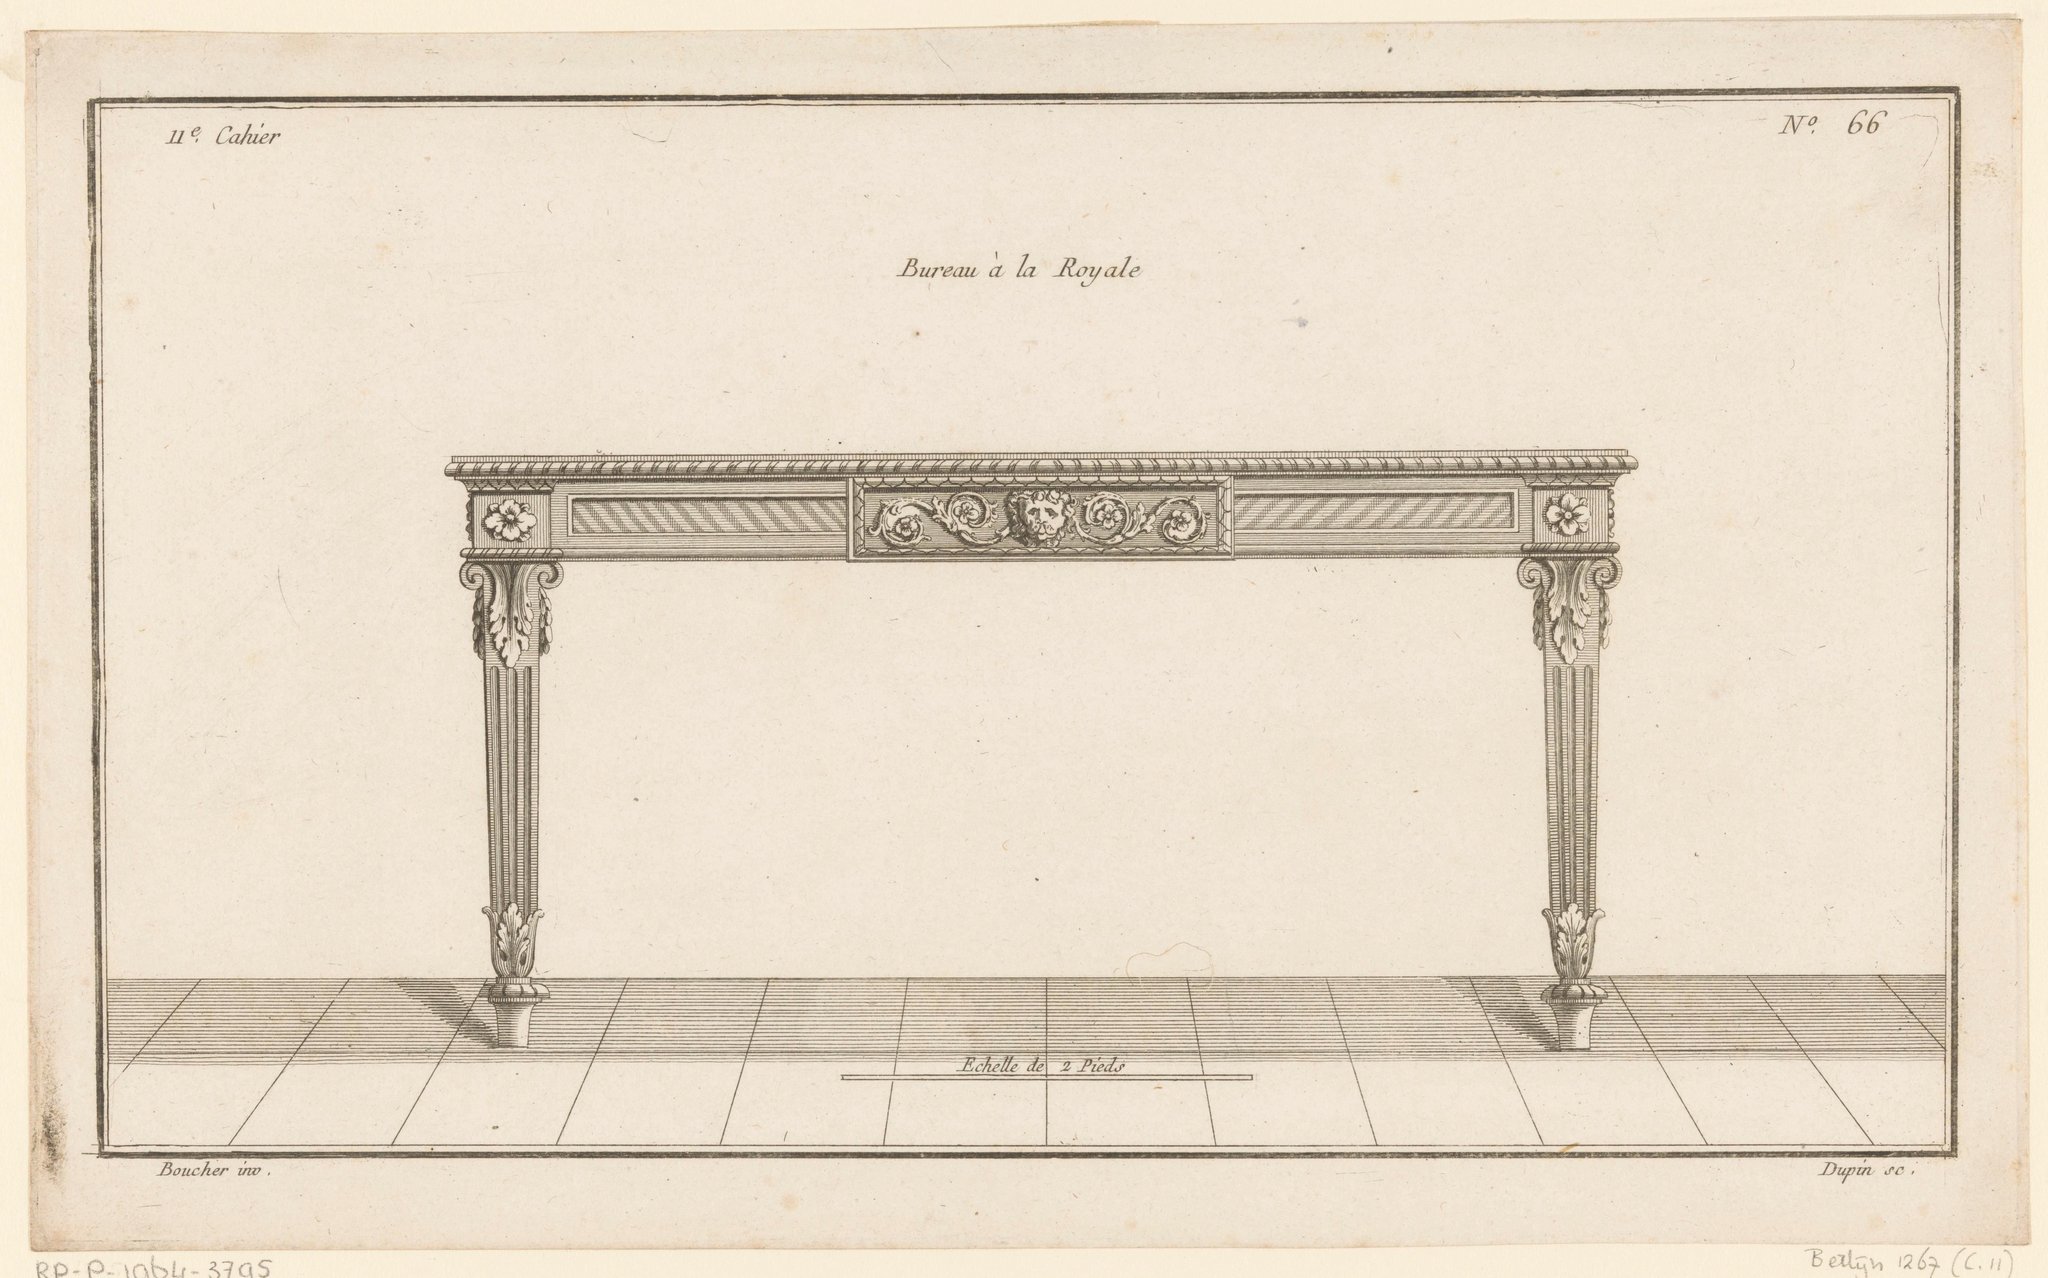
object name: ornament print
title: 11e Cahier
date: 1772-1779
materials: paper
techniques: engraving, etching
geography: paris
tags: writing-table, writing-desk, lion's head ~ ornament, ornament derived from plant forms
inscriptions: collector's mark: Lugt 2228, collector's mark: Lugt 2760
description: Een geornamenteerd bureau met blad- en bloemmotieven, ranken en een leeuwenkop. Prentnummer 66.